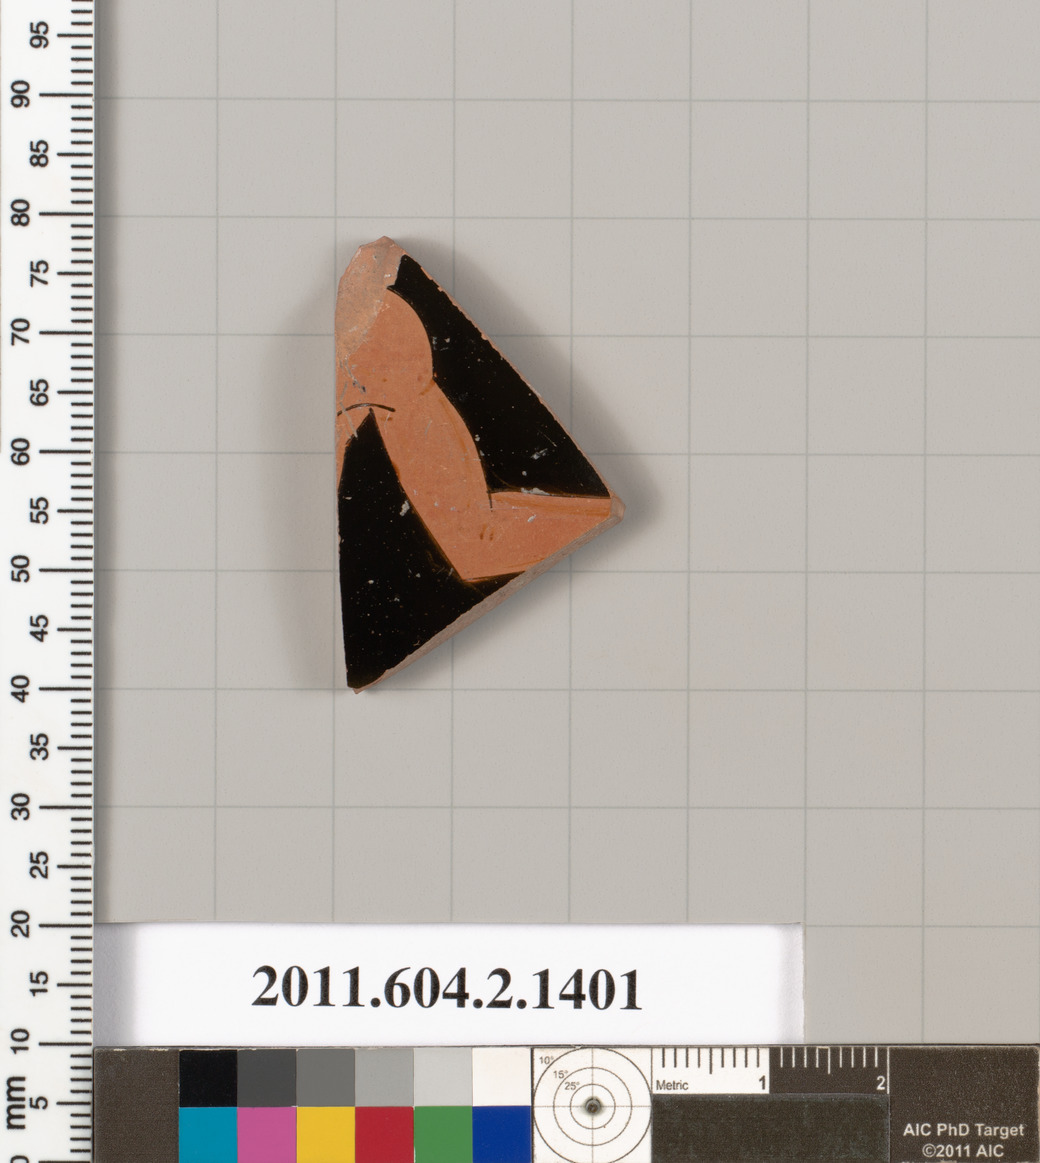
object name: skyphos fragment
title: Terracotta fragment of a skyphos (deep drinking cup)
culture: greek, attic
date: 475-451 BCE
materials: terracotta